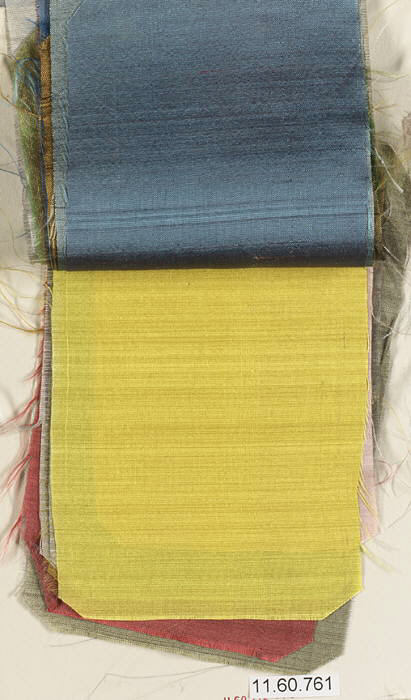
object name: sample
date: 1801-1833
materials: silk